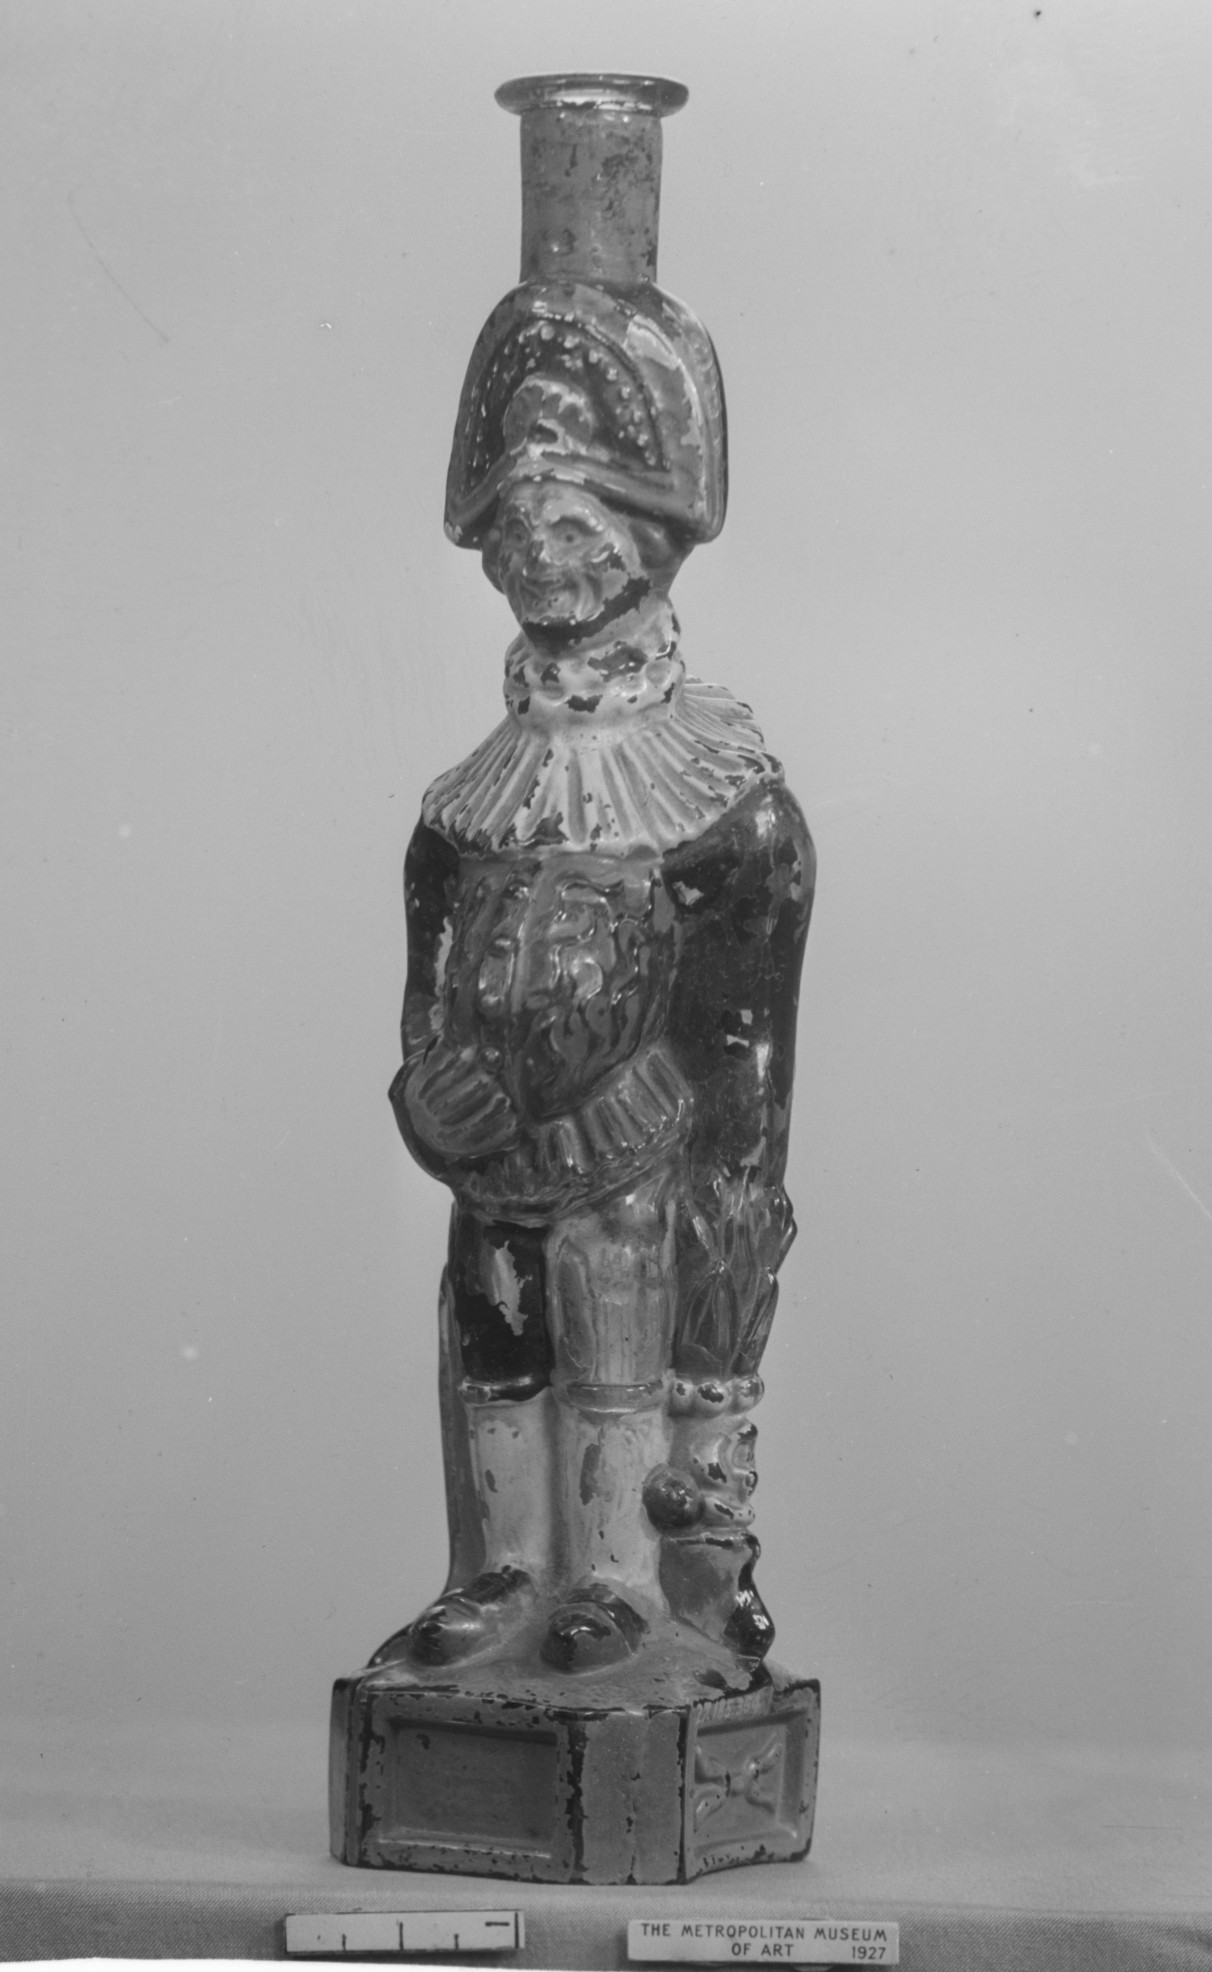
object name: bottle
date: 1801-1850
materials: glass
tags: men,puppets